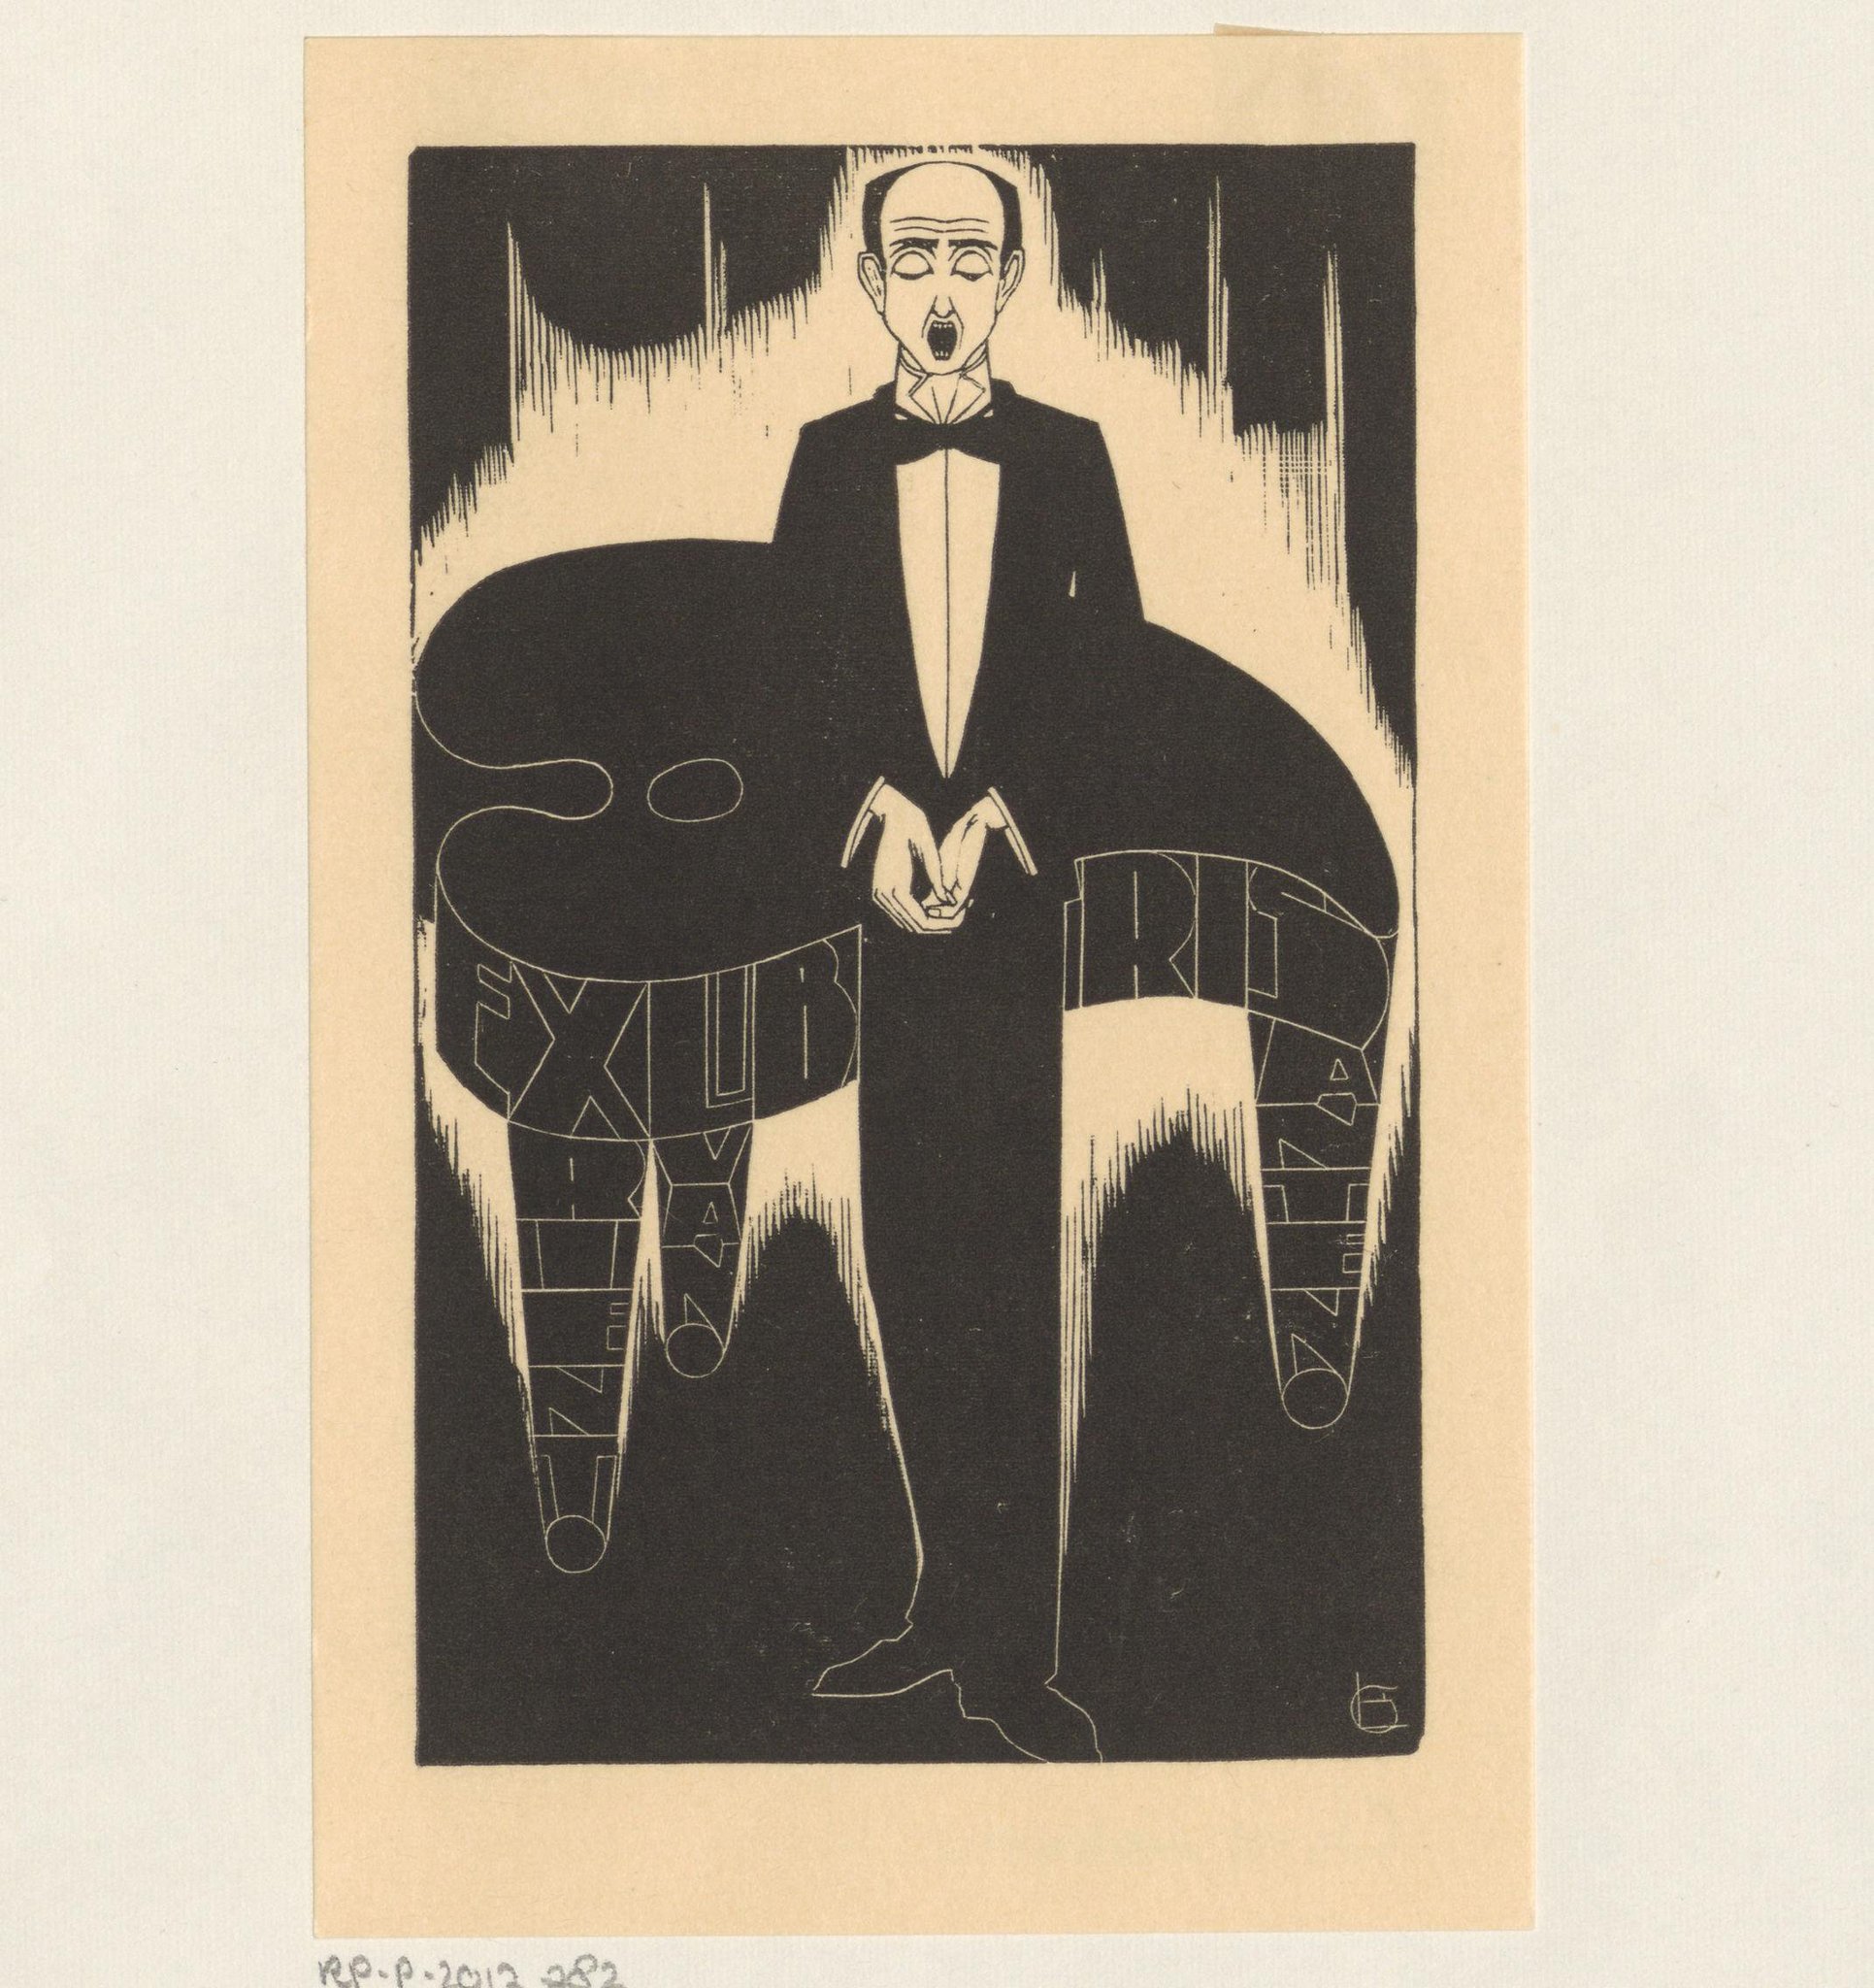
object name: bookplate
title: Ex libris van Rient van Santen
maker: chris lebeau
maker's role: draughtsman, print maker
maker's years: 1878-1945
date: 1937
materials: paper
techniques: engraving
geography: netherlands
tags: the hague, painter, rient van santen, male singer, grand piano, palette